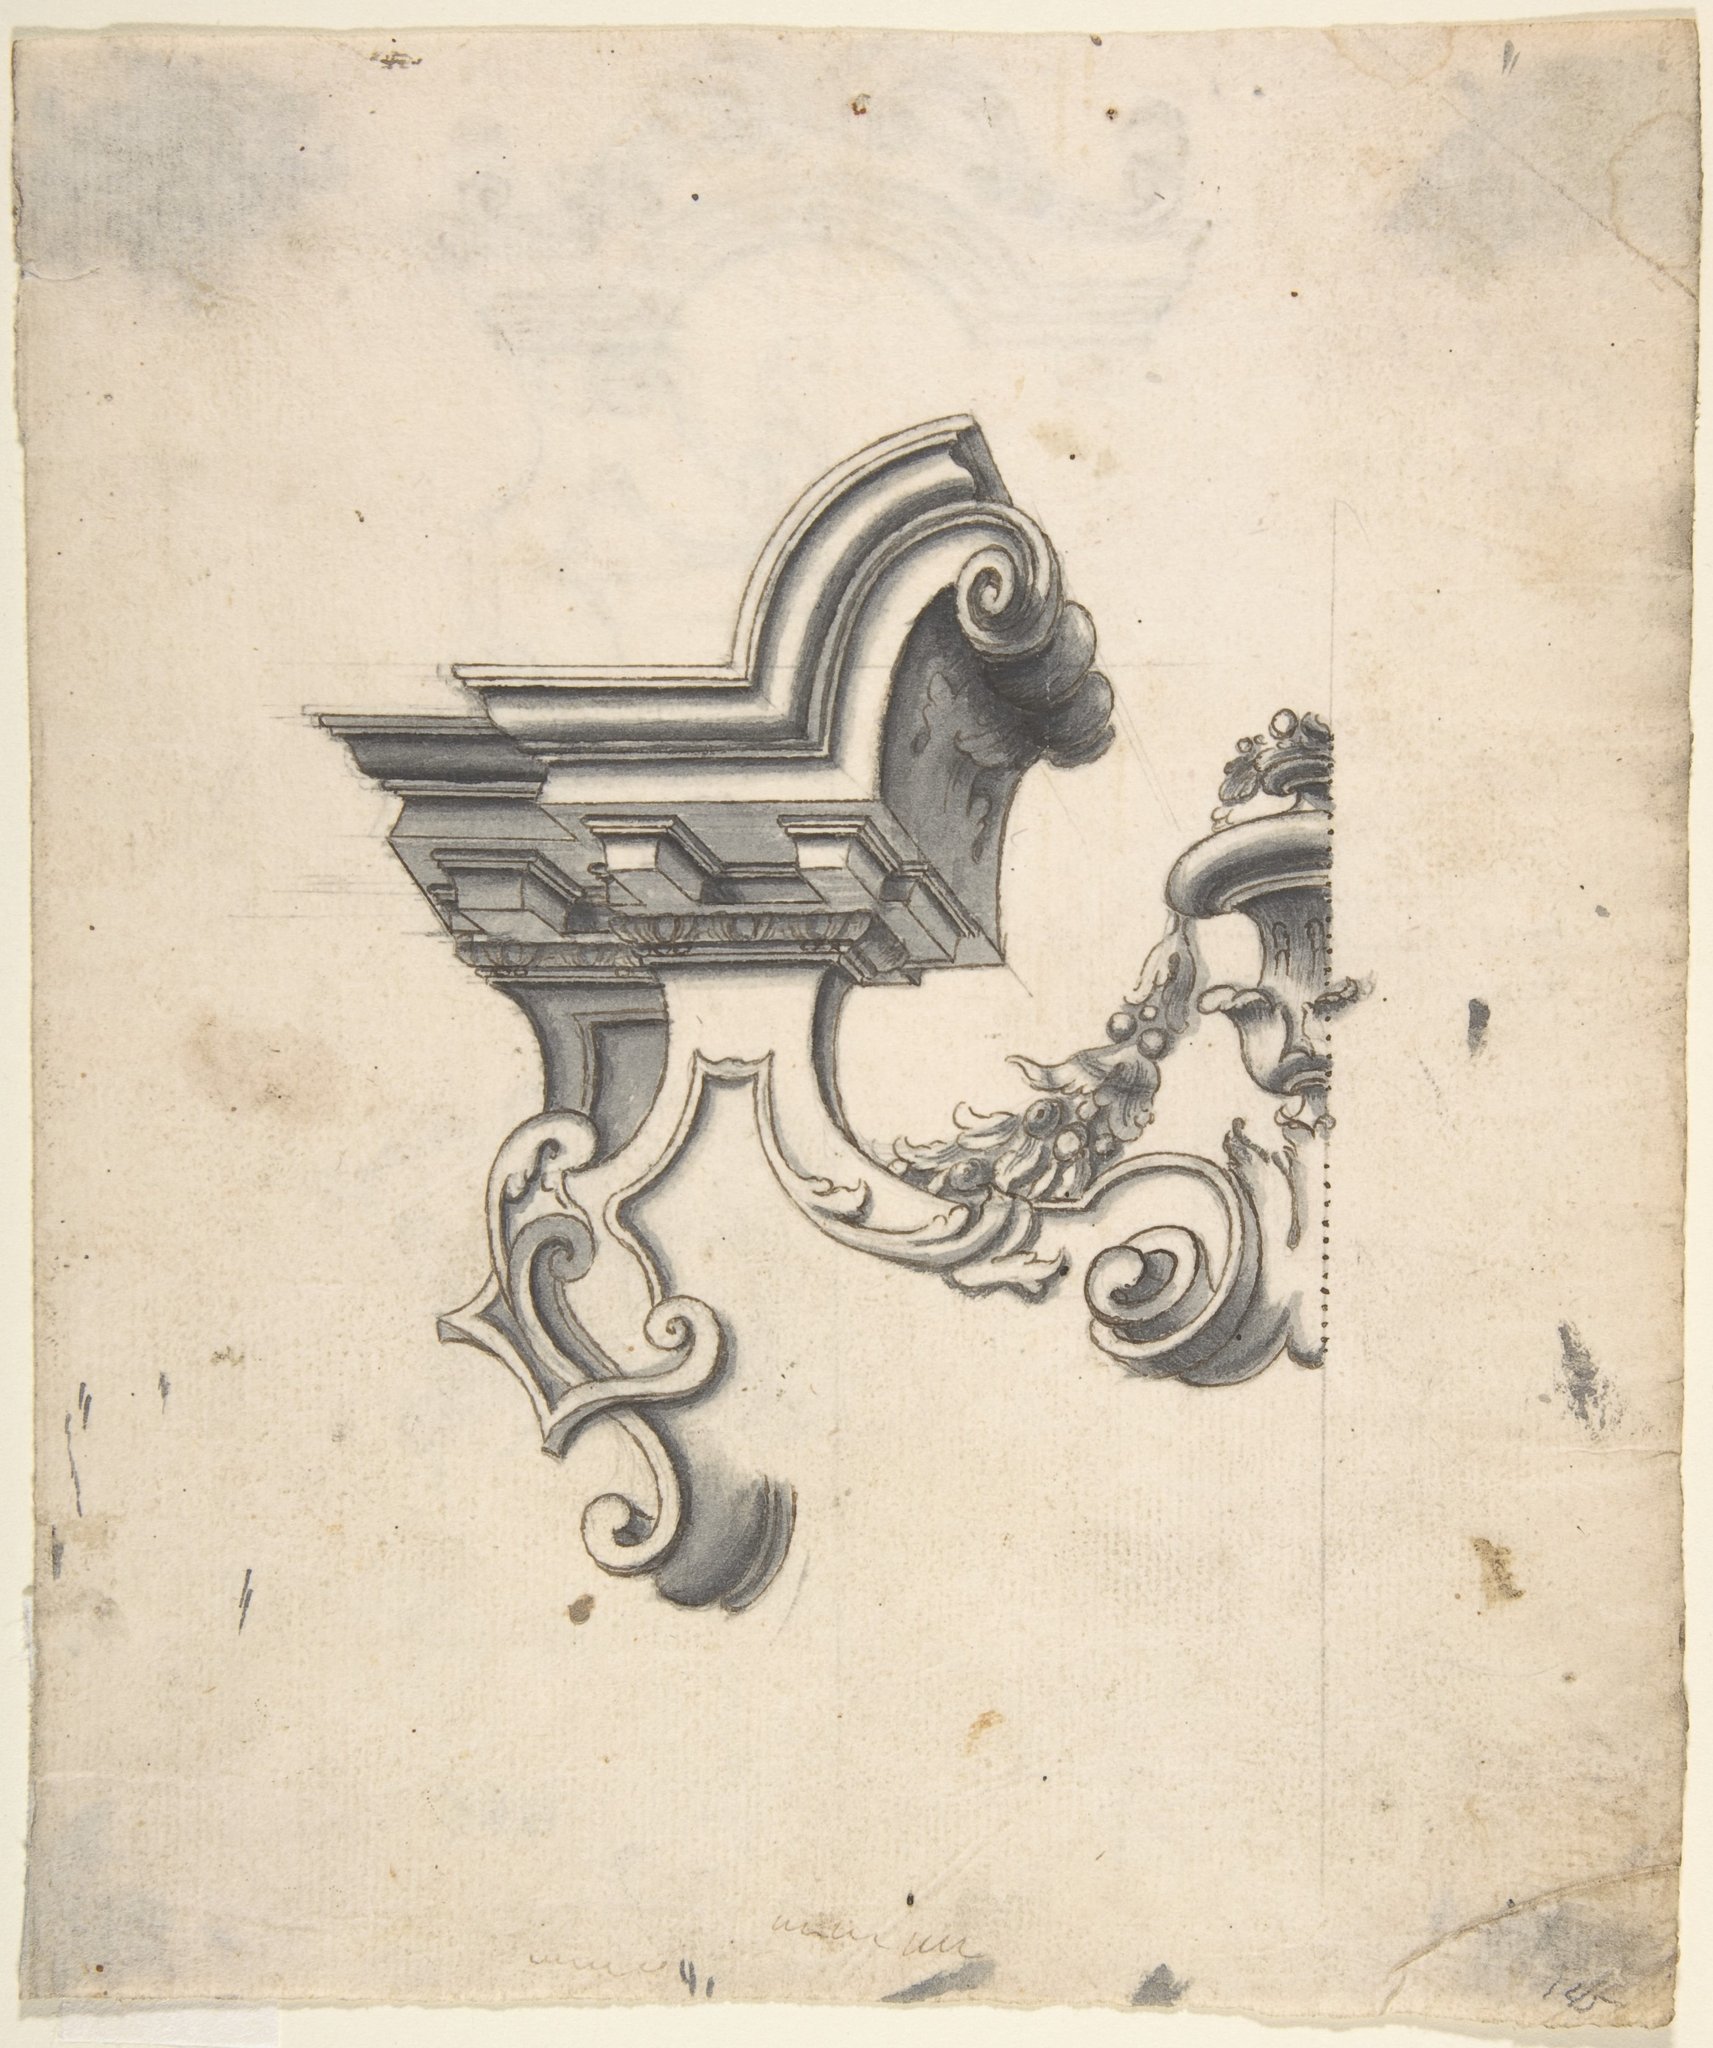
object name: drawing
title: One Half of a Design for an Overdoor (?) (recto); Two Designs for Altars, one for a Capital (?) (verso)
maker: anonymous, italian, piedmontese, 18th century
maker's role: artist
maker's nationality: italian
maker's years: 1700-1800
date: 1700-1780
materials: graphite, ink, drawing material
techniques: brush, pen, wash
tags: architecture